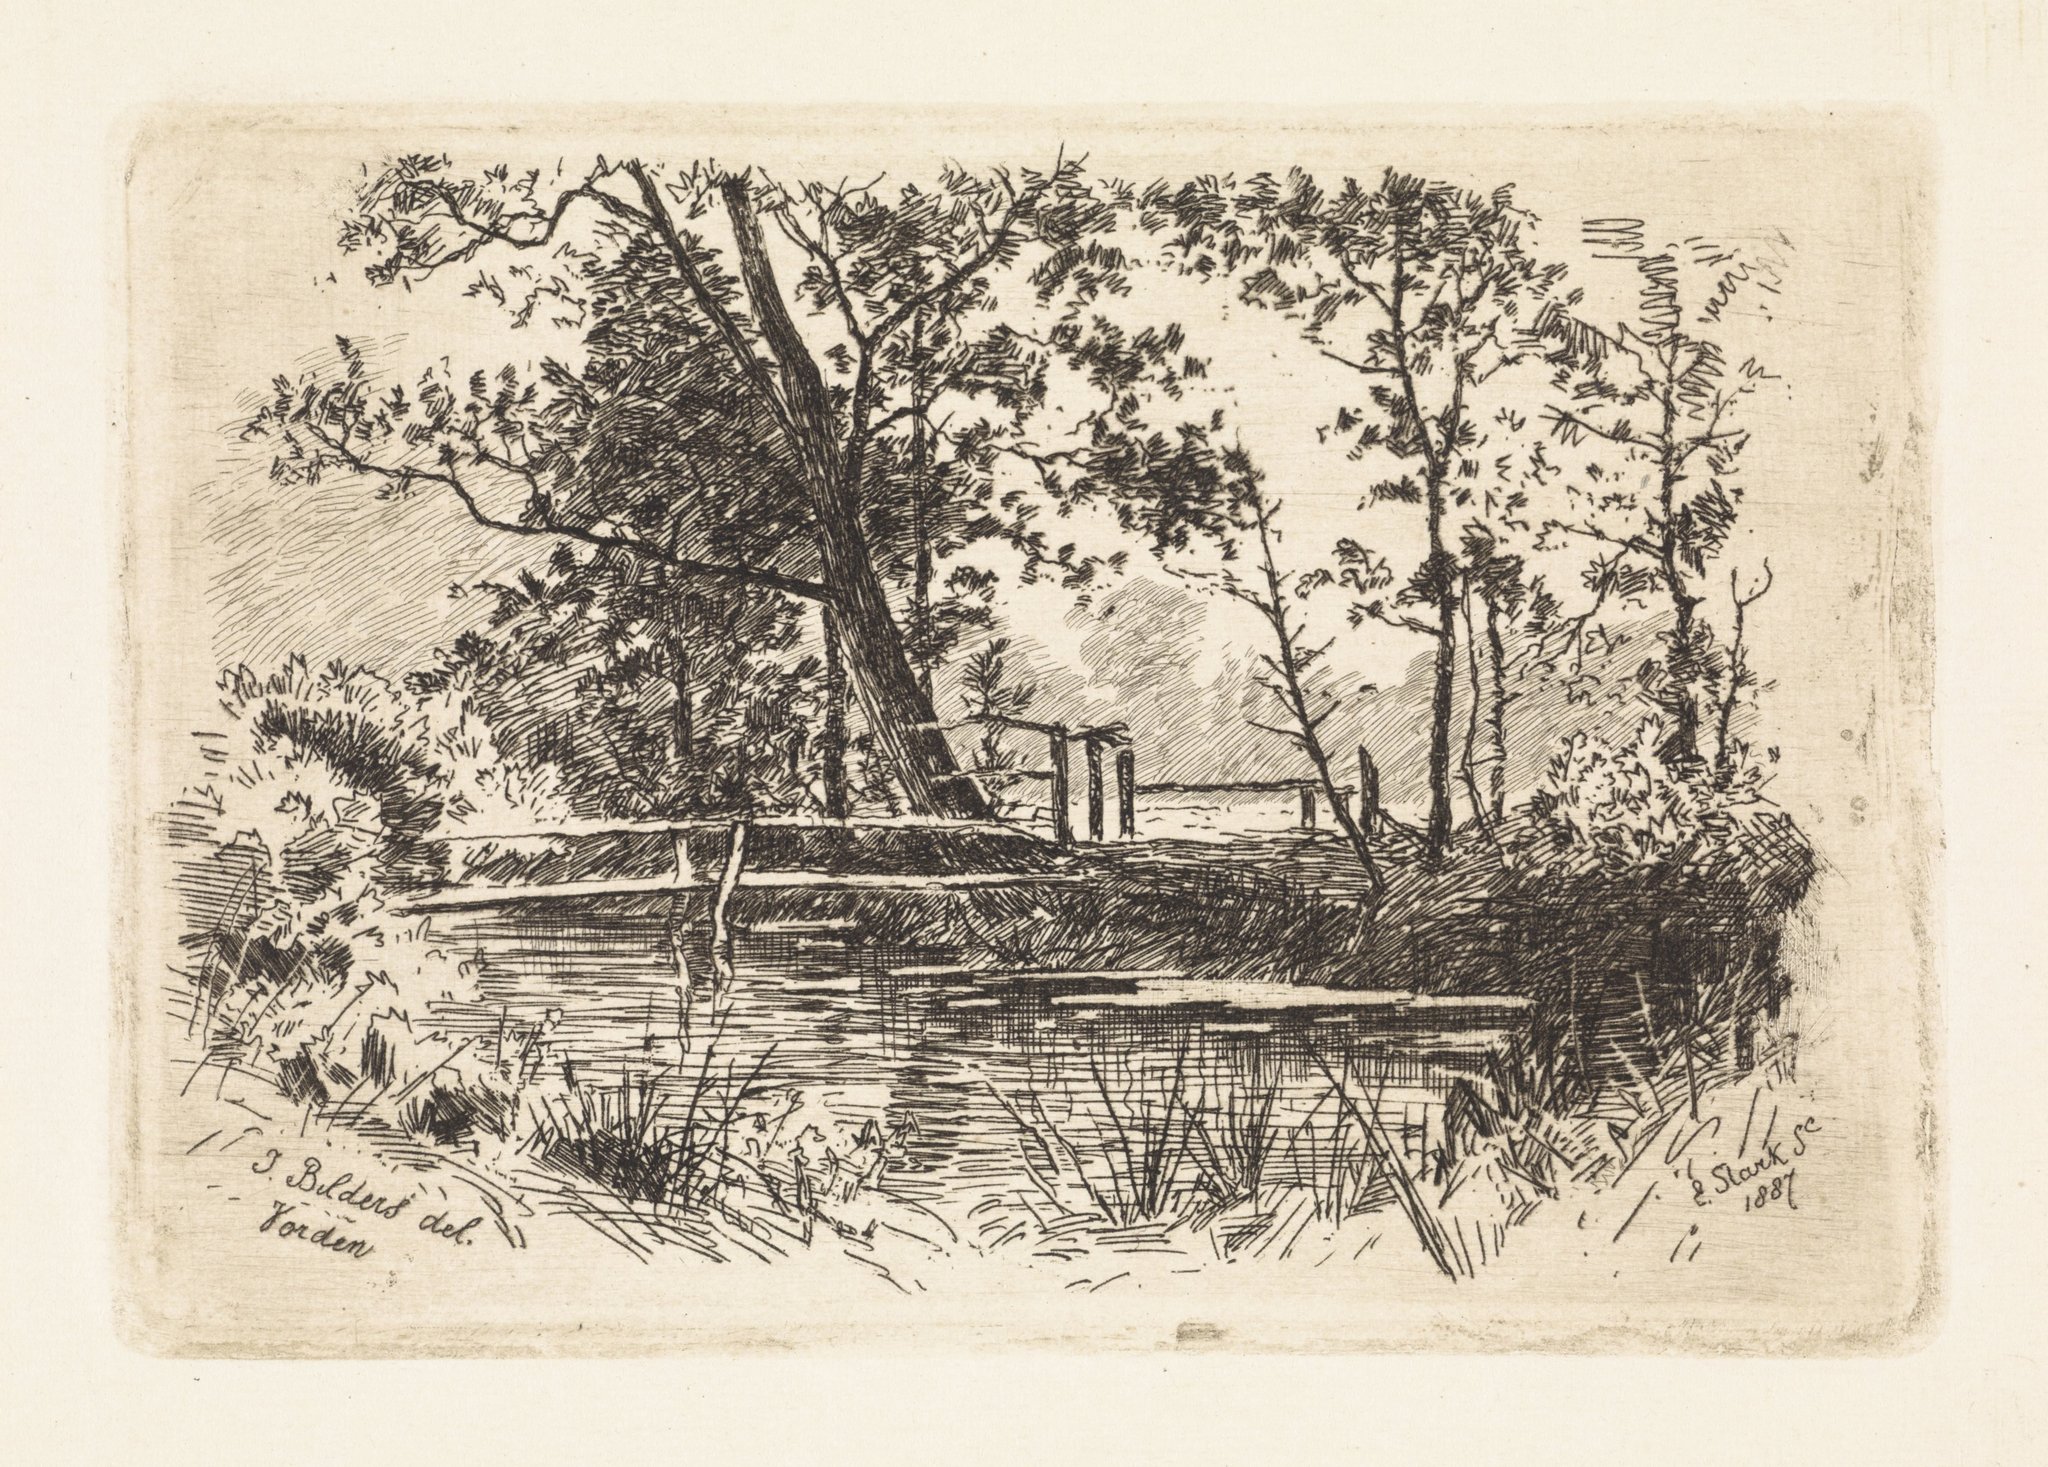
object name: print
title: Landschap met sloot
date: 1887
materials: paper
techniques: etching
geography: vorden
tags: trees, water course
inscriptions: collector's mark: Lugt 2228